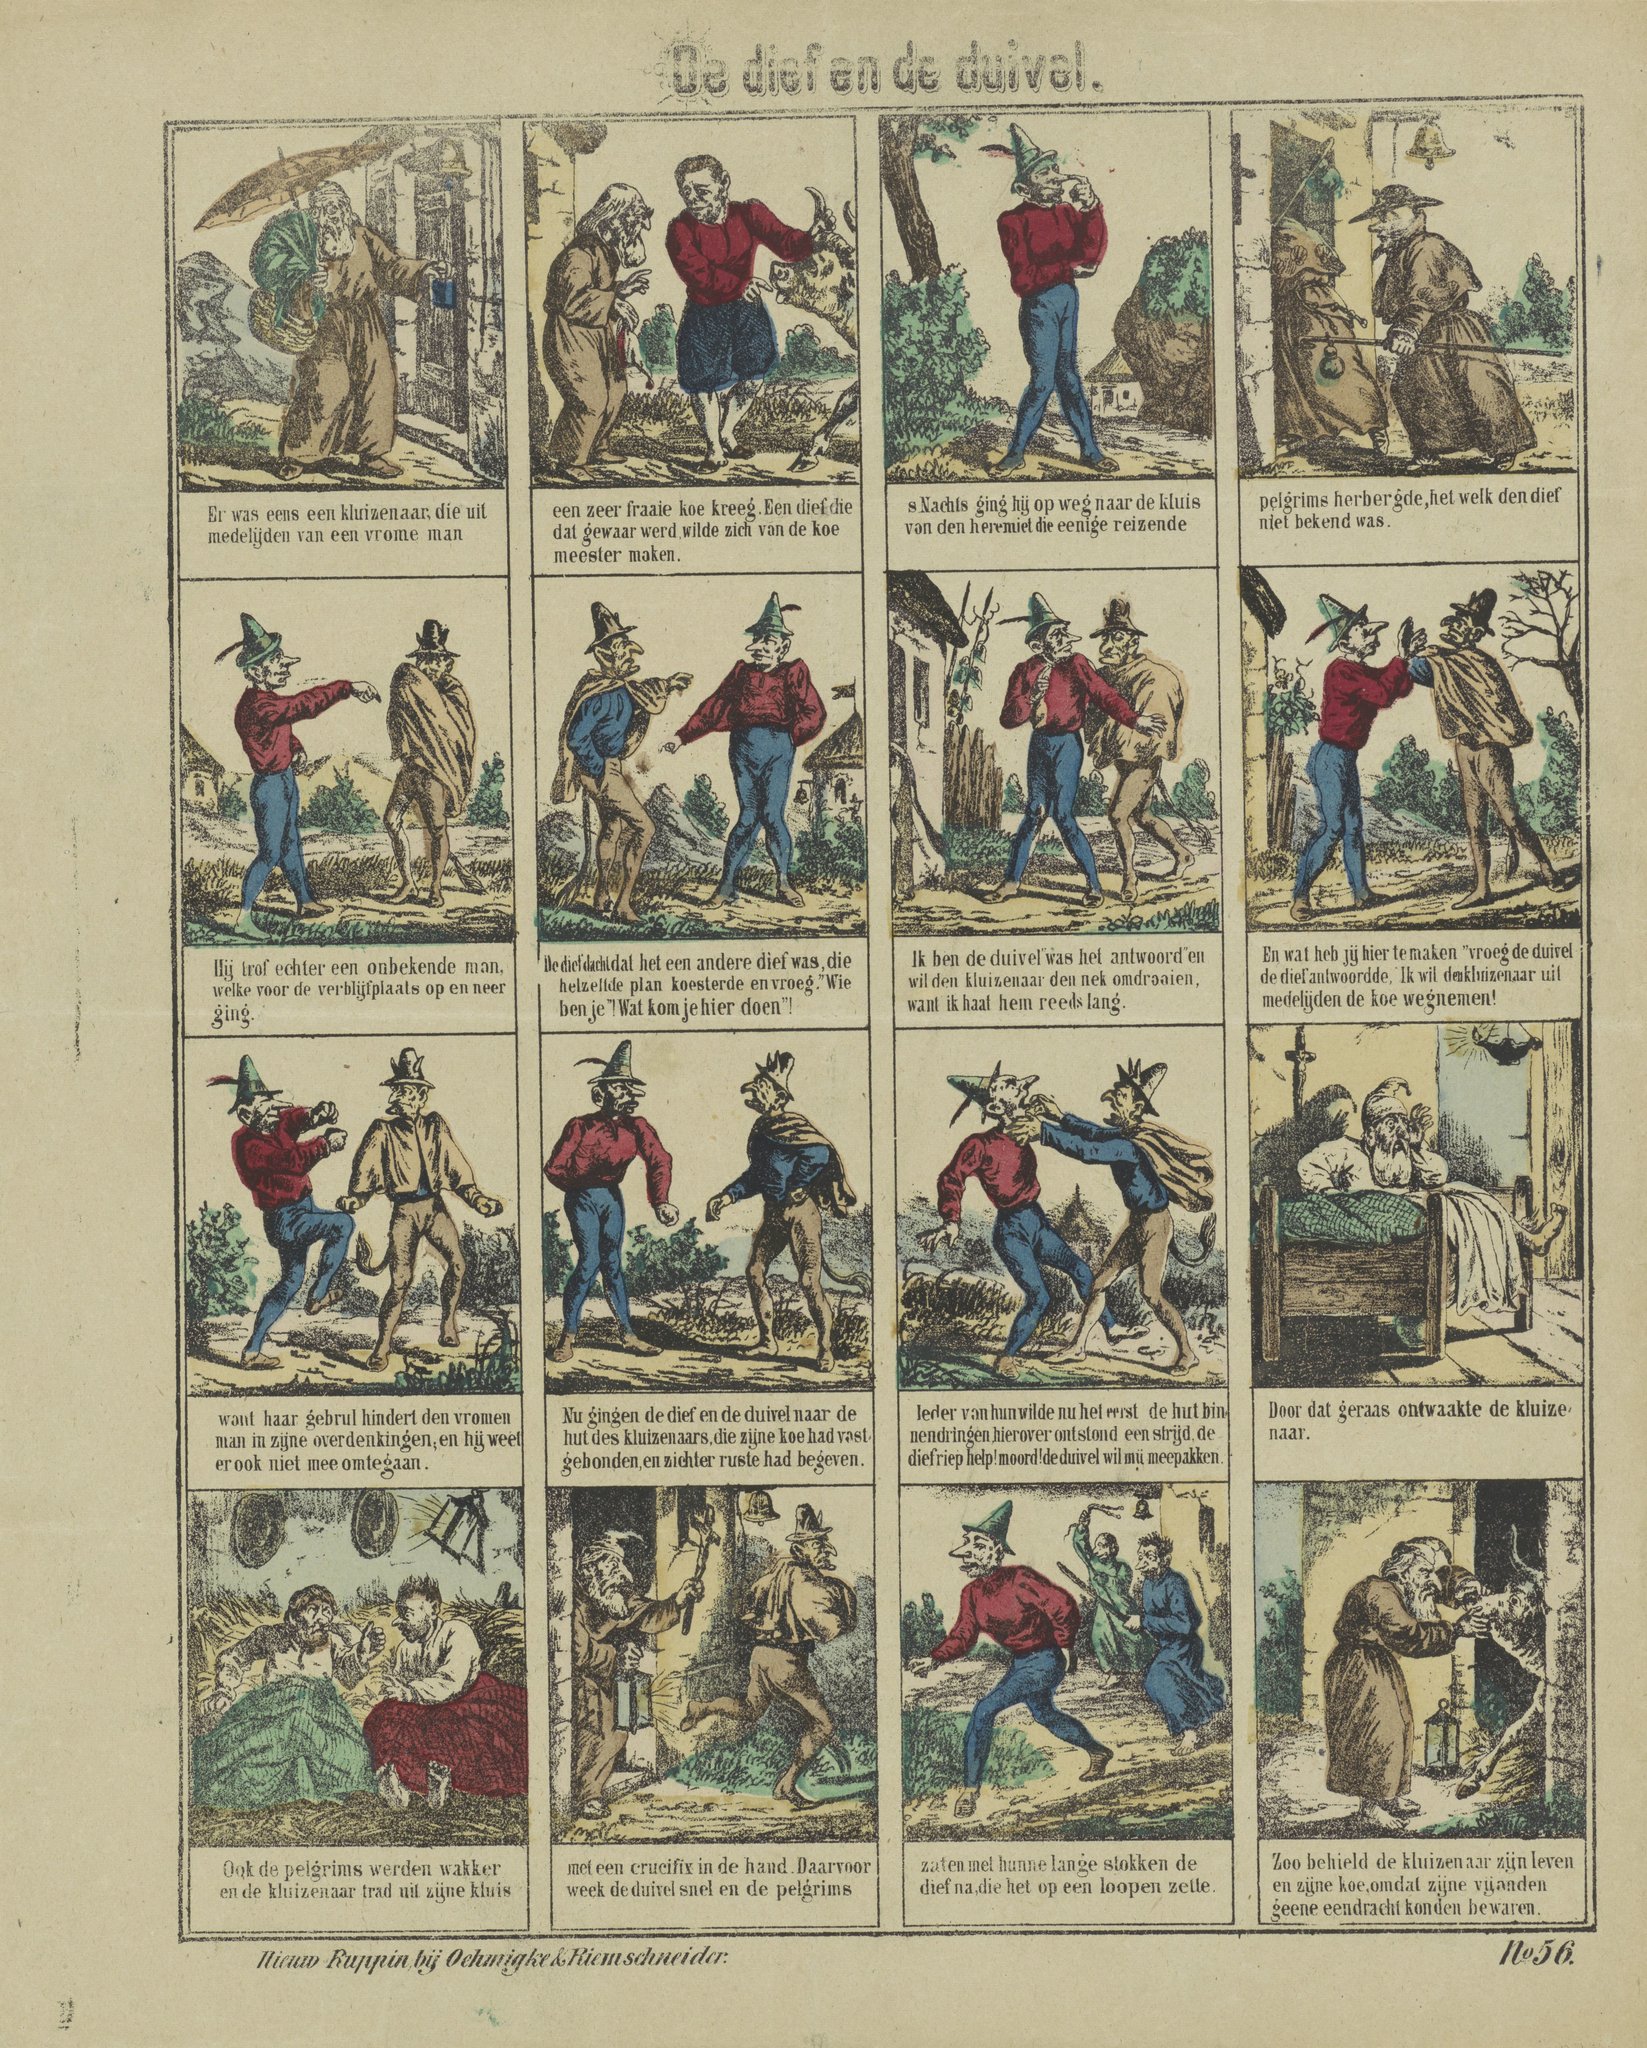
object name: print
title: De dief en de duivel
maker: Anonymous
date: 1828-1937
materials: paper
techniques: hand coloring, letterpress printing, lithograph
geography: neuruppin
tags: devil(s) and demons, thief, tales and fairy tales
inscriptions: collector's mark: Lugt 2760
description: Blad met 16 voorstellingen uit het verhaal van de dief en de duivel. Onder elke afbeelding een onderschrift. Genummerd rechtsonder: No. 56.